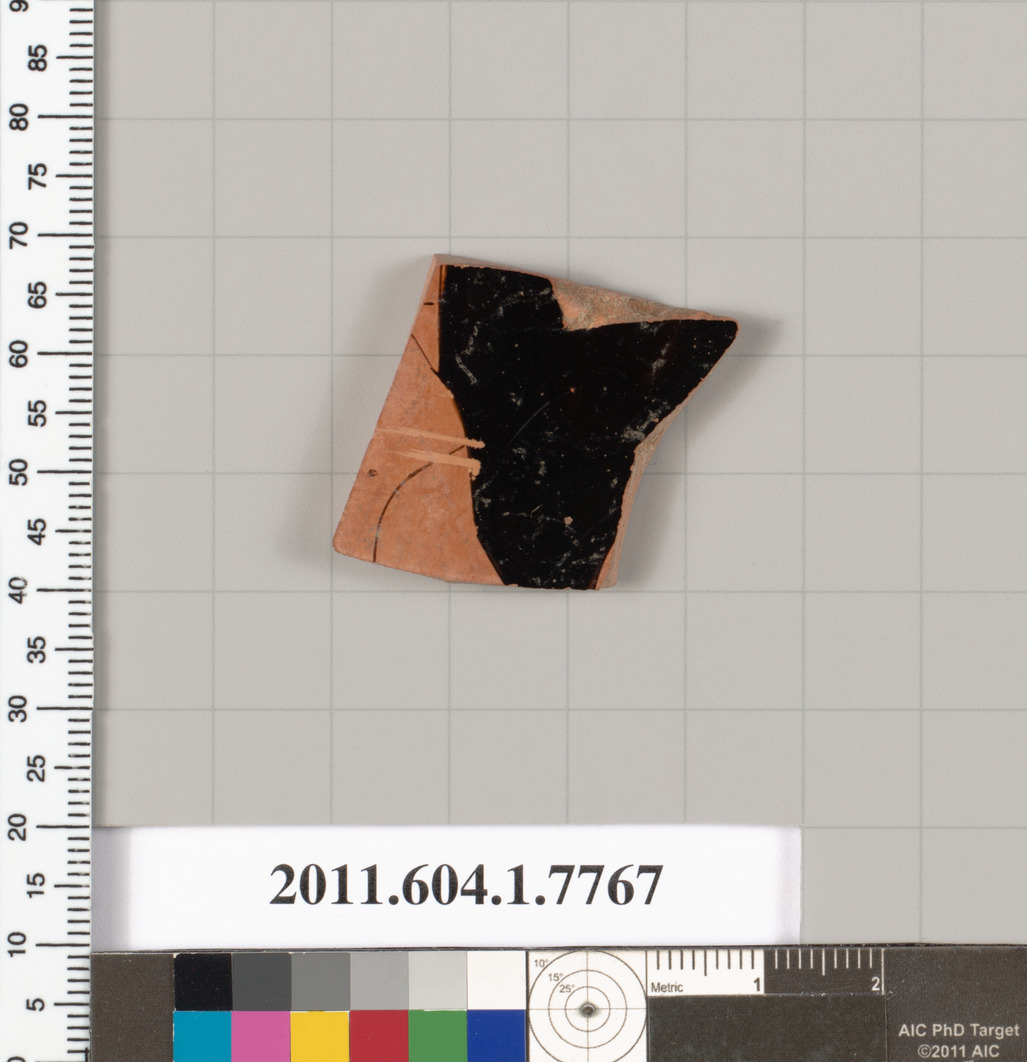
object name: kylix fragment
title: Terracotta fragment of a kylix (drinking cup)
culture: greek, attic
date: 460-450 BCE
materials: terracotta